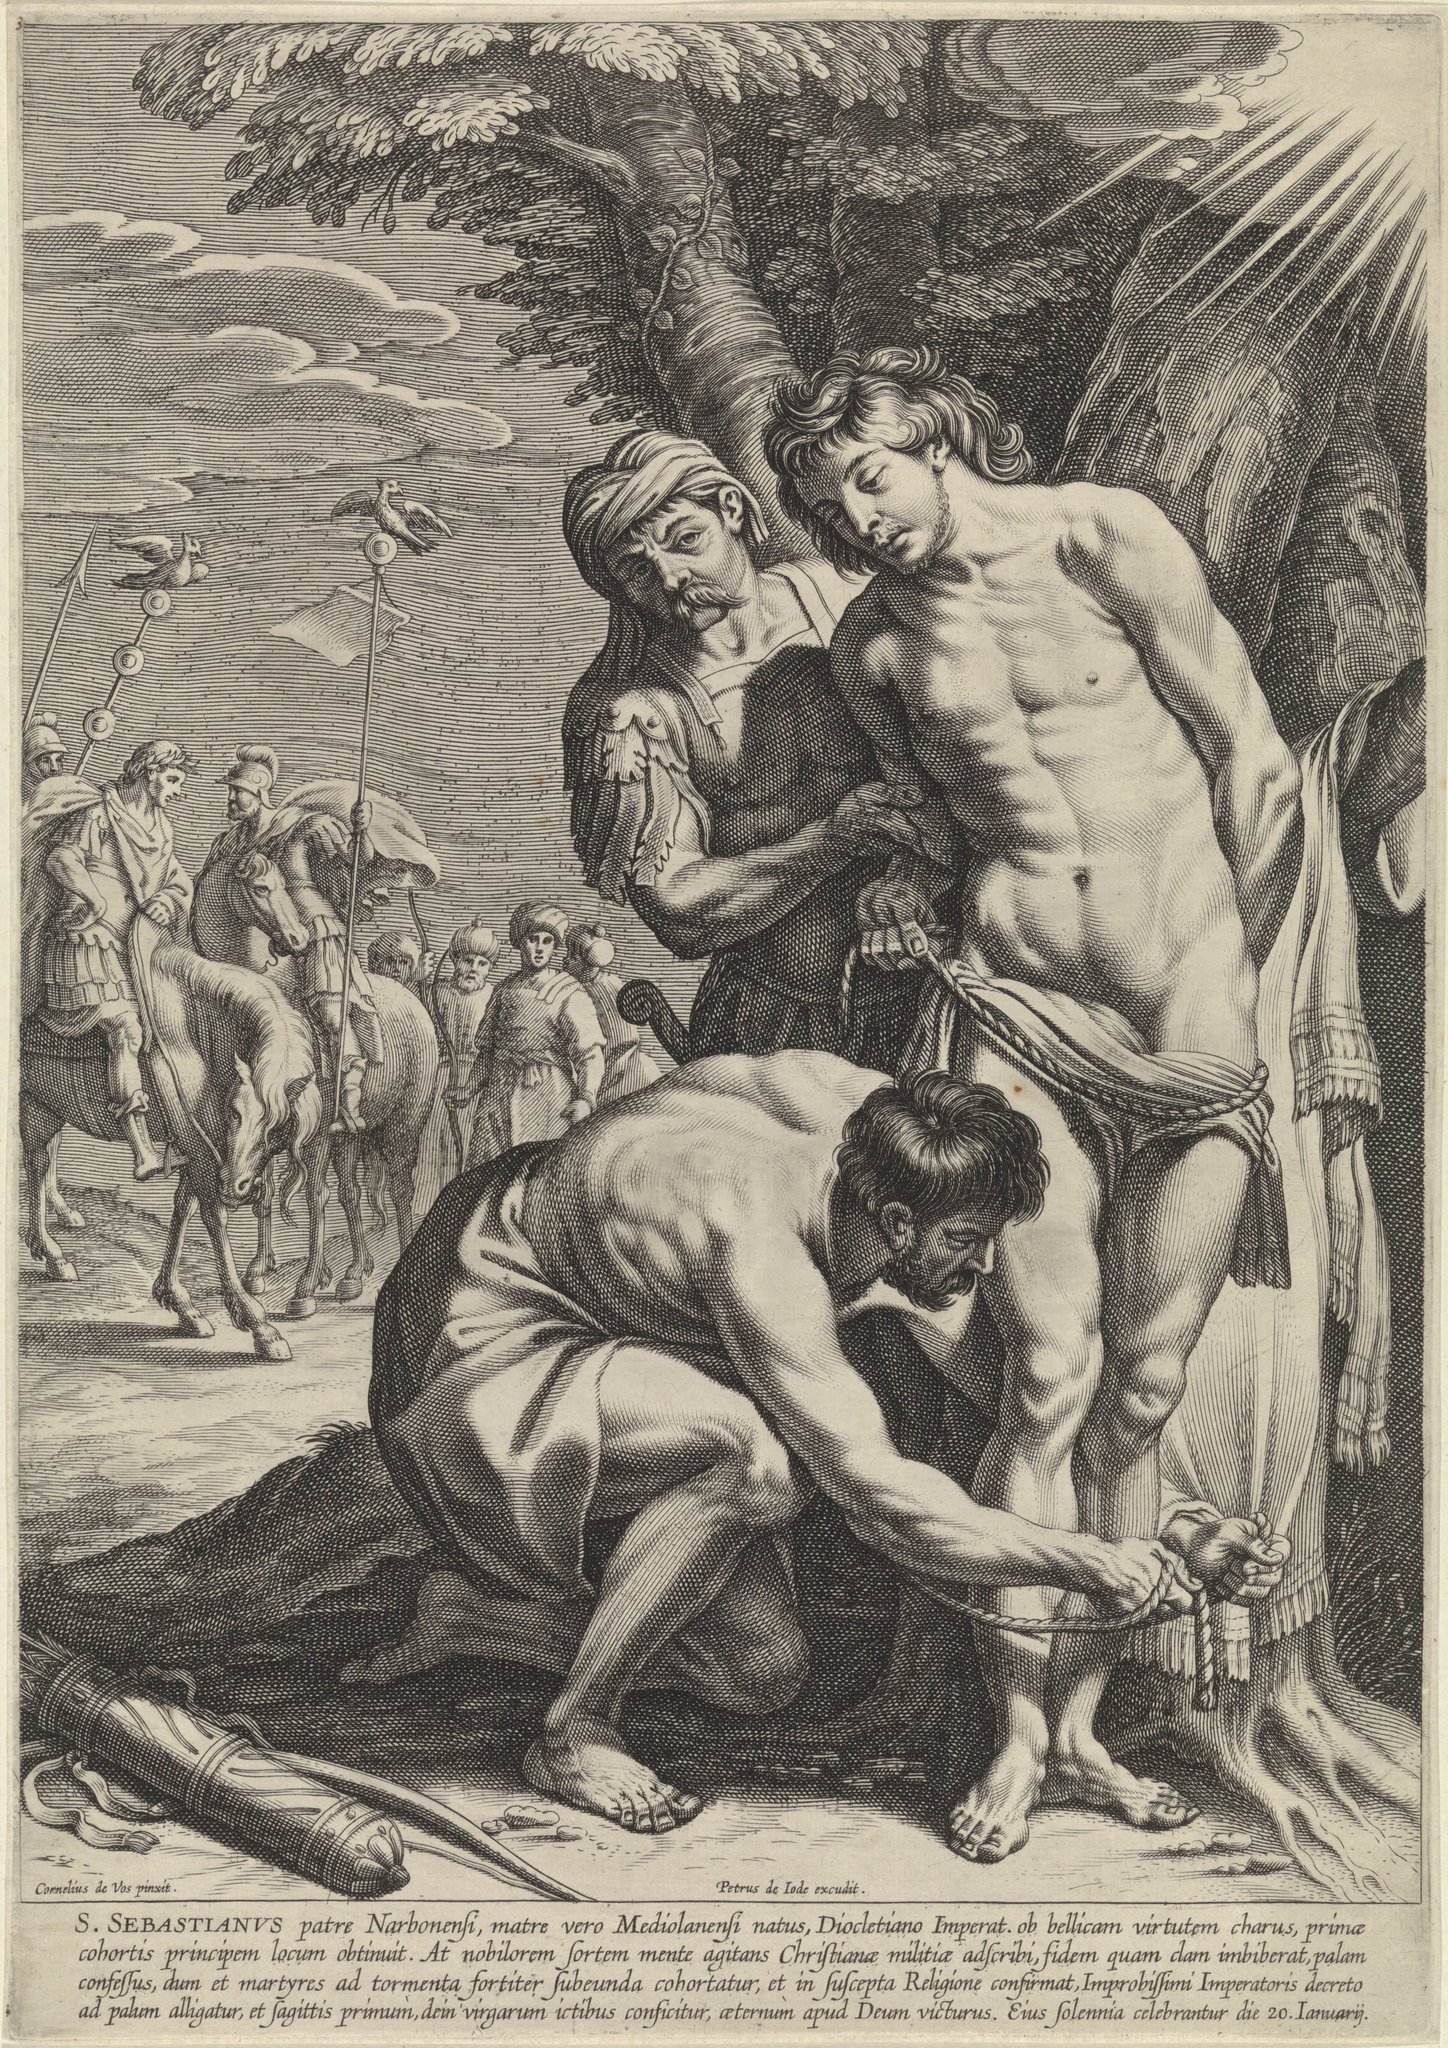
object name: print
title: Martelaarschap van H. Sebastiaan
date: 1590-1637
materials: paper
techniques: engraving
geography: antwerp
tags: martyrdom, suffering, misfortune, death of st. sebastian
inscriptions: collector's mark: Lugt 240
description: De heilige Sebastiaan wordt door twee soldaten met touwen vastgebonden aan een boom. Op de voorgrond ligt een pijlenkoker. Op de achtergrond een groep soldaten, van wie enkelen te paard. In de marge een vierregelig onderschrift in het Latijn.